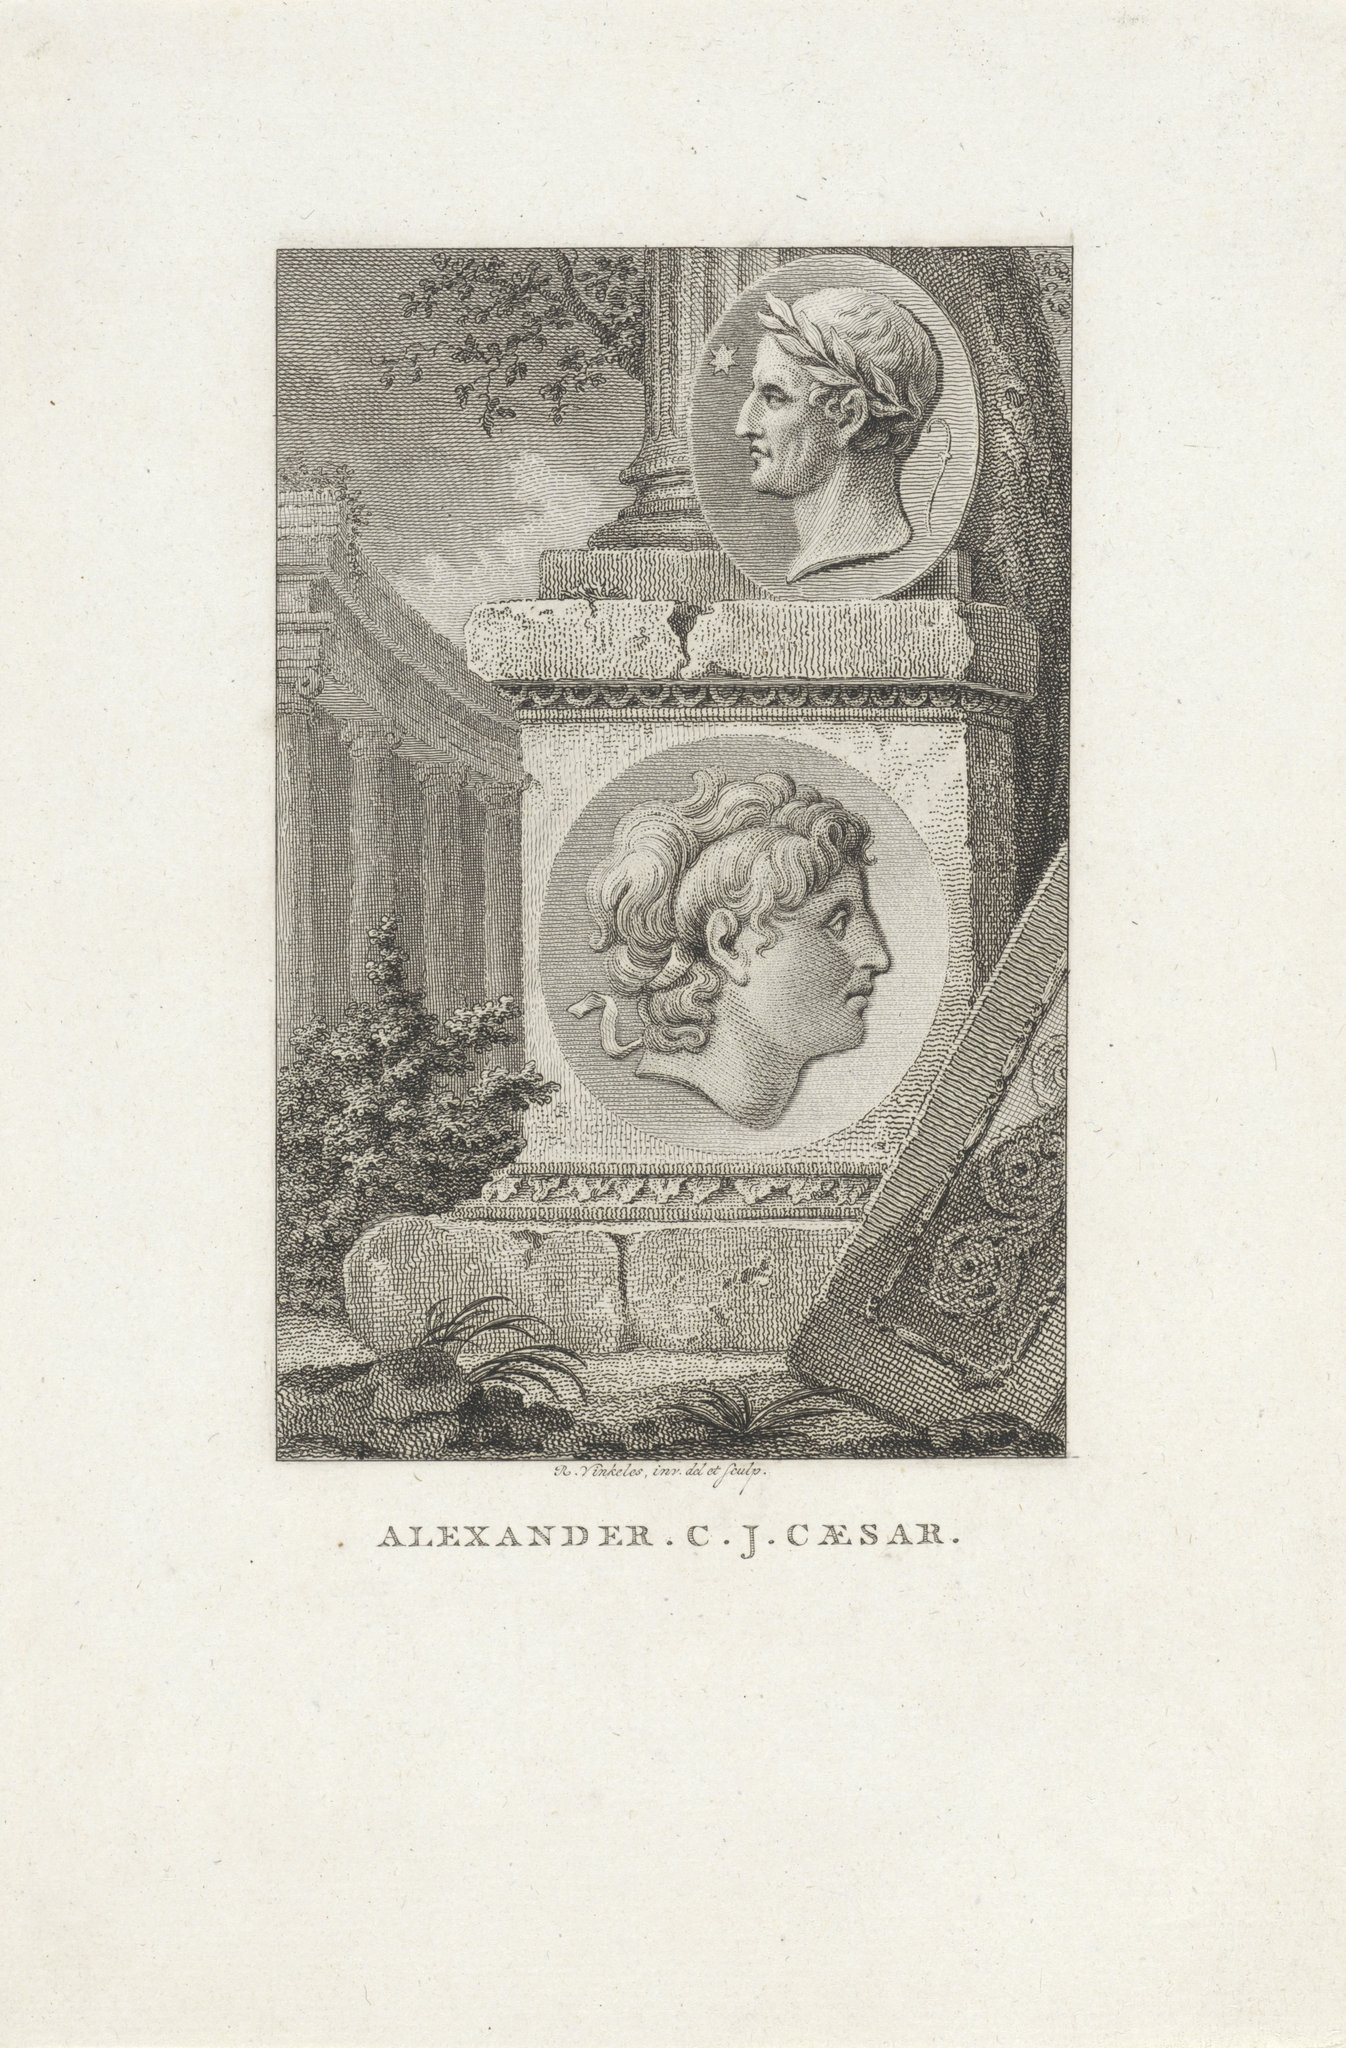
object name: print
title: Medaillons met portretten van Alexander de Grote en Julius Ceasar op een pilaar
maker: reinier vinkeles (i)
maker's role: draughtsman, print maker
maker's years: 1741-1816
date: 1789-1809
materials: paper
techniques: etching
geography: amsterdam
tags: column, pillar ~ architecture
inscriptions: collector's mark: Lugt 240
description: Prent ook gebruikt als boekillustratie in: Plutarchus [bewerkt door E. Wassenbergh en H. Bosscha]. De levens van doorluchtige Grieken en Romeinen, onderling vergeleeken (...). 12 dln. Amsterdam: Johannes Allart, 1789-1809.